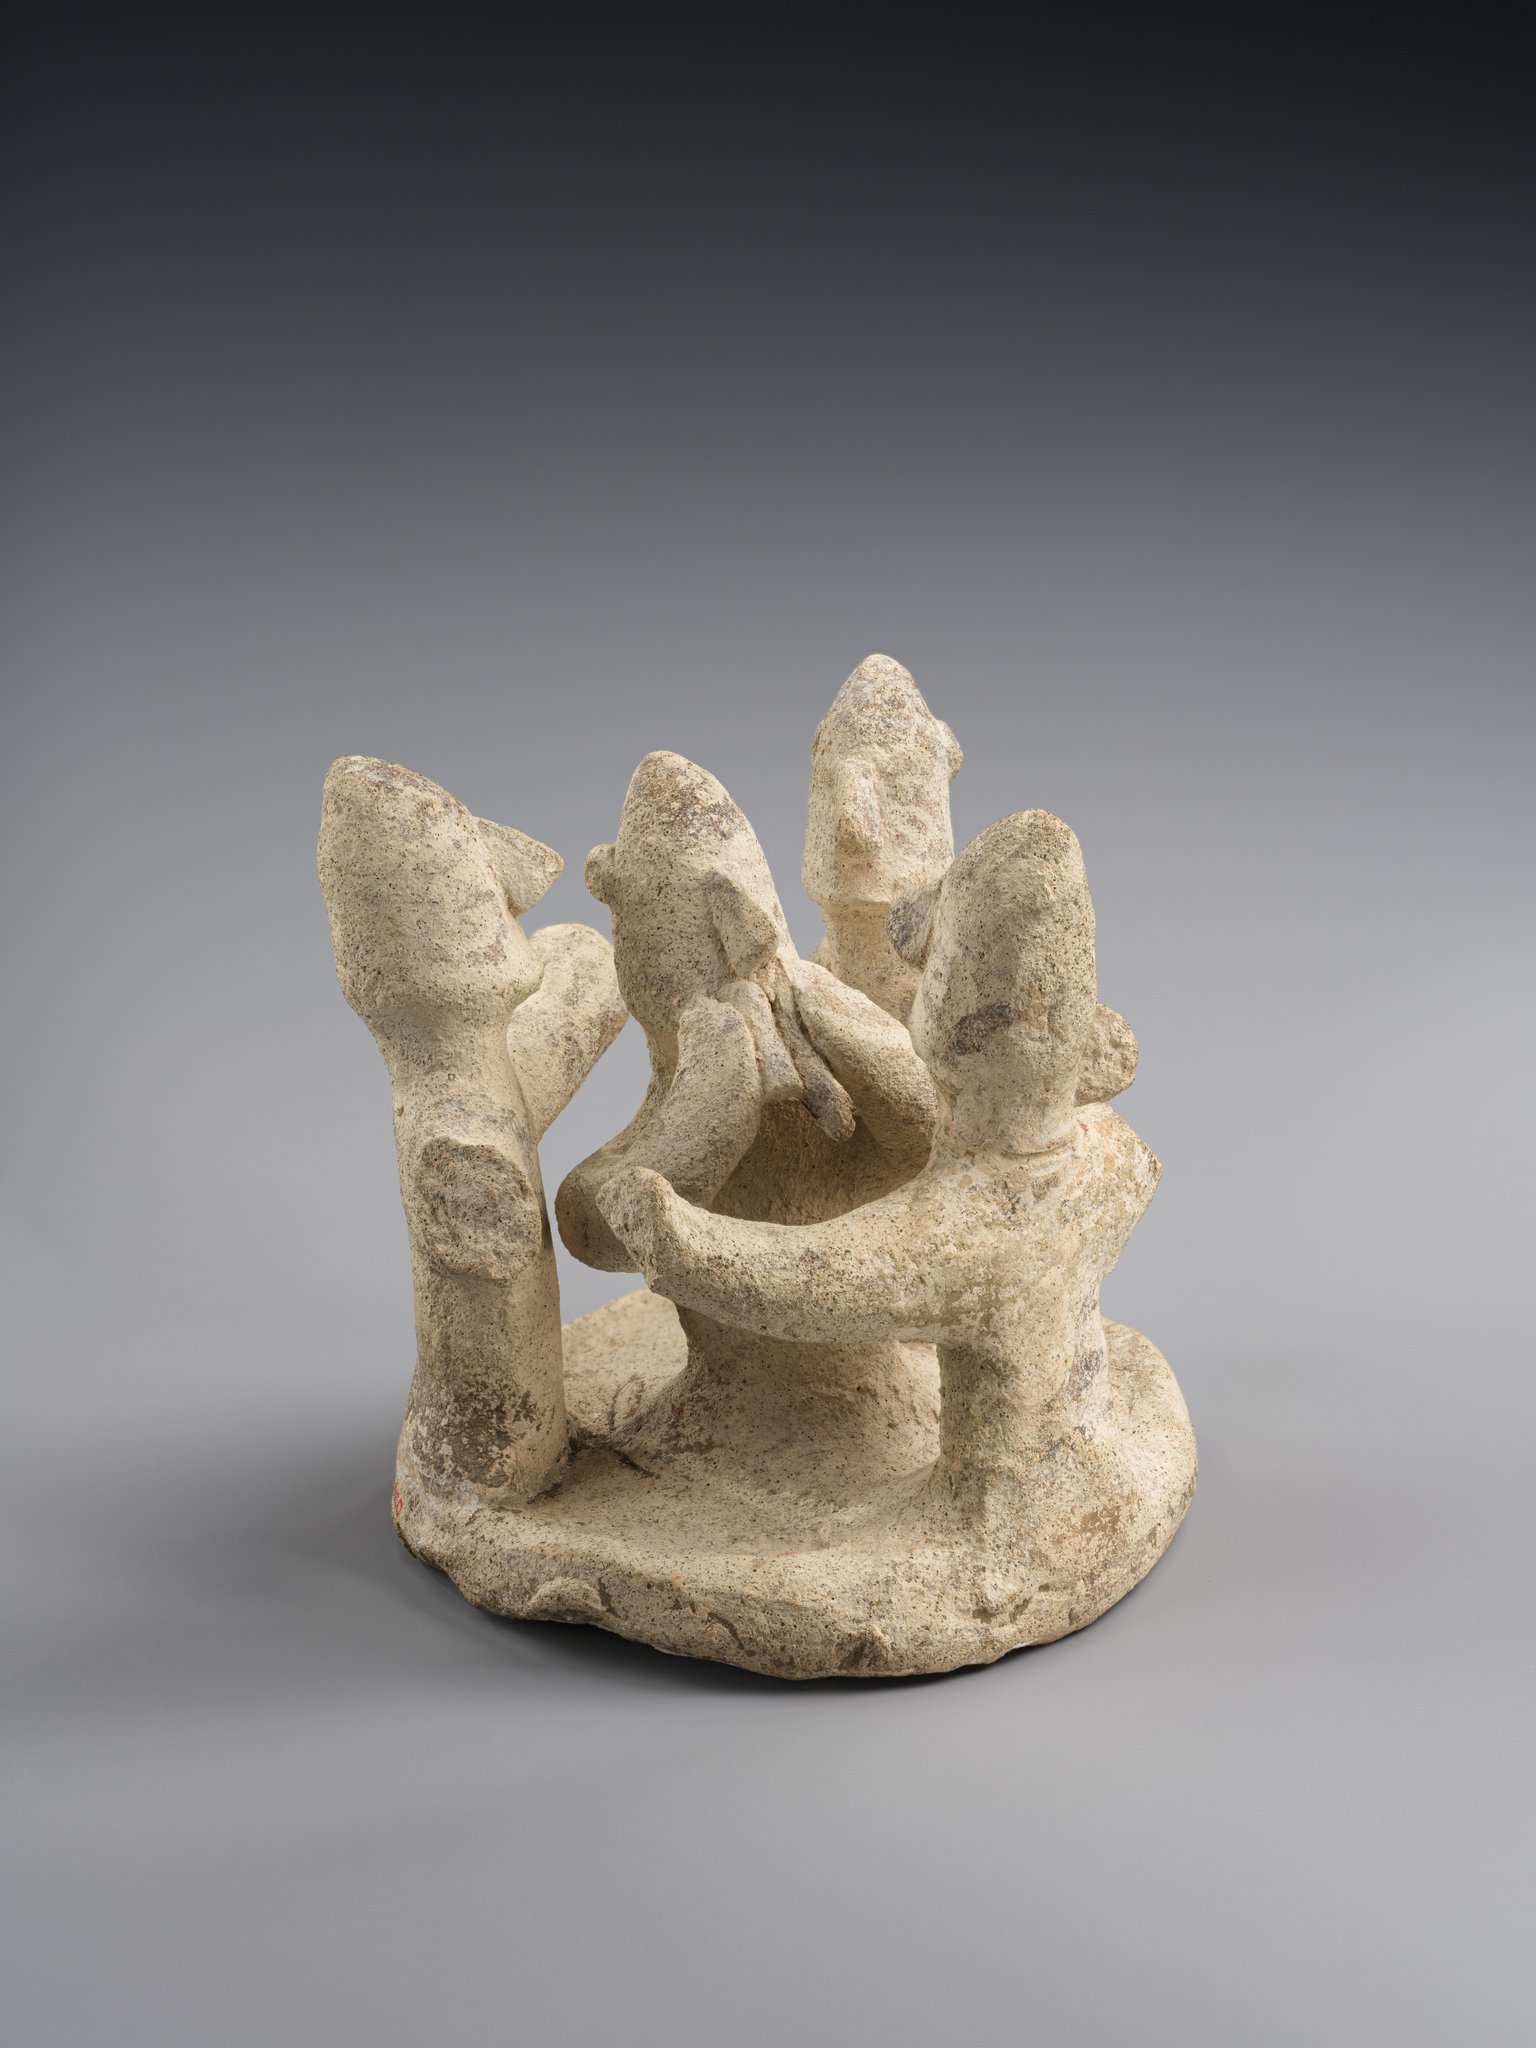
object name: ring dance with flute player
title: Terracotta statuette of a ring dance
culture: cypriot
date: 600-501 BCE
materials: terracotta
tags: dancing,flutes,dancers,musicians